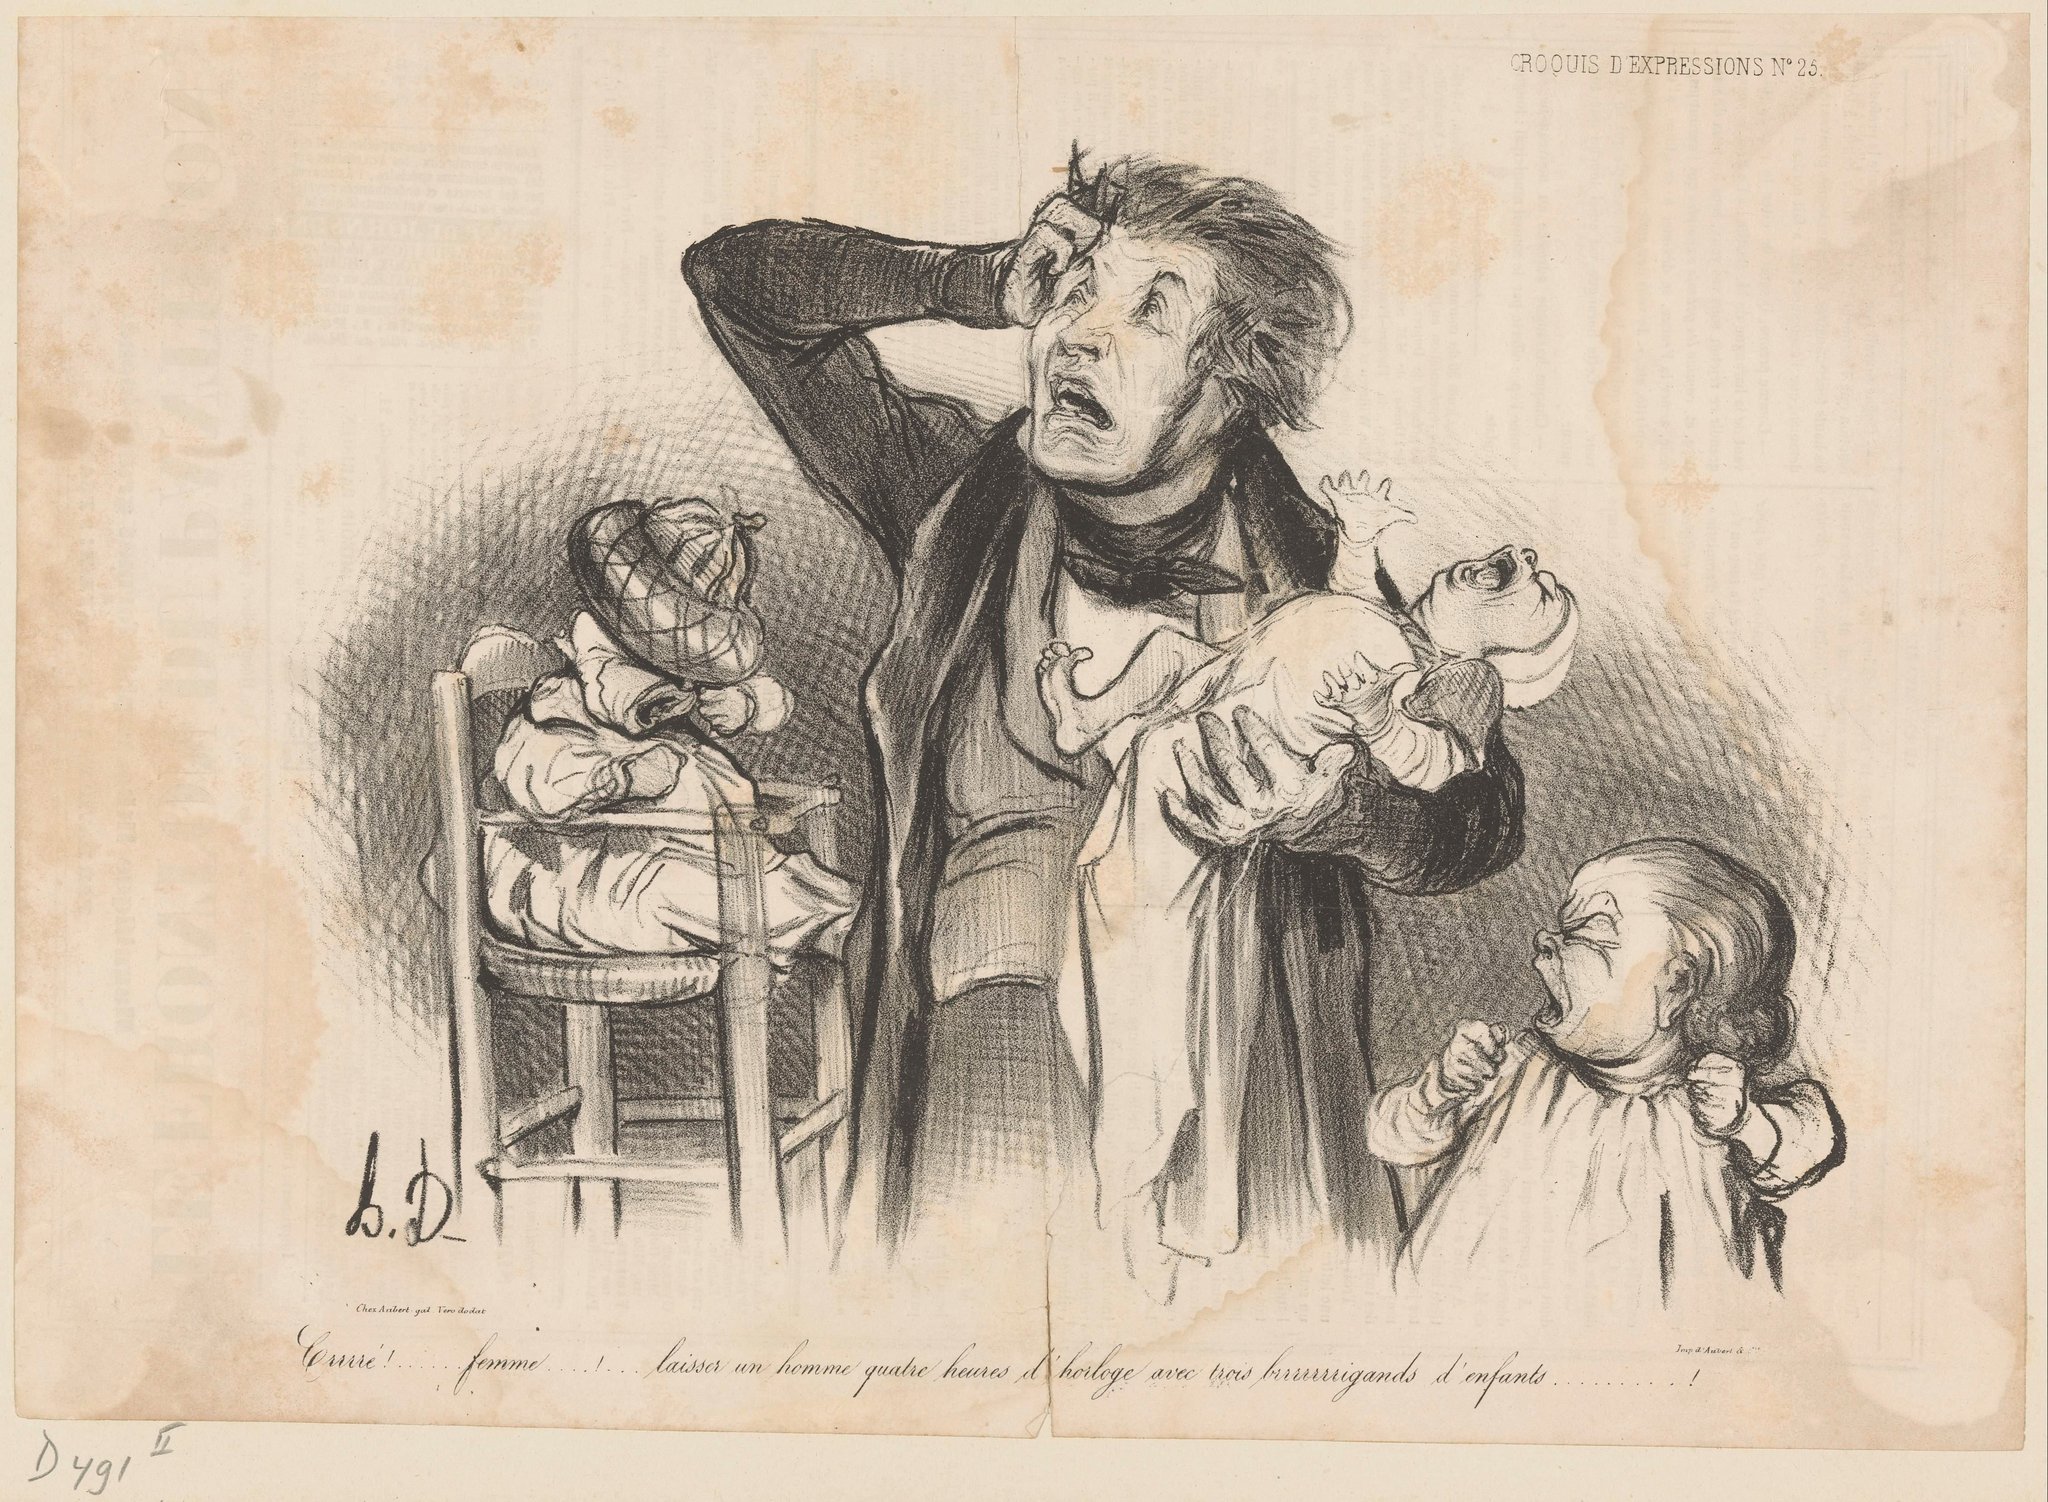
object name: cartoon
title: Crrrré!.. Femme!.. Laisser un homme quatre heures d'horloge avec trois brrrrrigands d'enfants!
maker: honoré daumier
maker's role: draughtsman, painter, print maker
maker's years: 1808-1879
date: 1838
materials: paper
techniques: letterpress printing, lithograph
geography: paris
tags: baby-sitter, caricatures (human types), father and child(ren), man and child(ren) (family group) (with number of children)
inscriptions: collector's mark: Lugt 2228a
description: Prent mogelijk uit: Le Charivari, 28 augustus 1838.